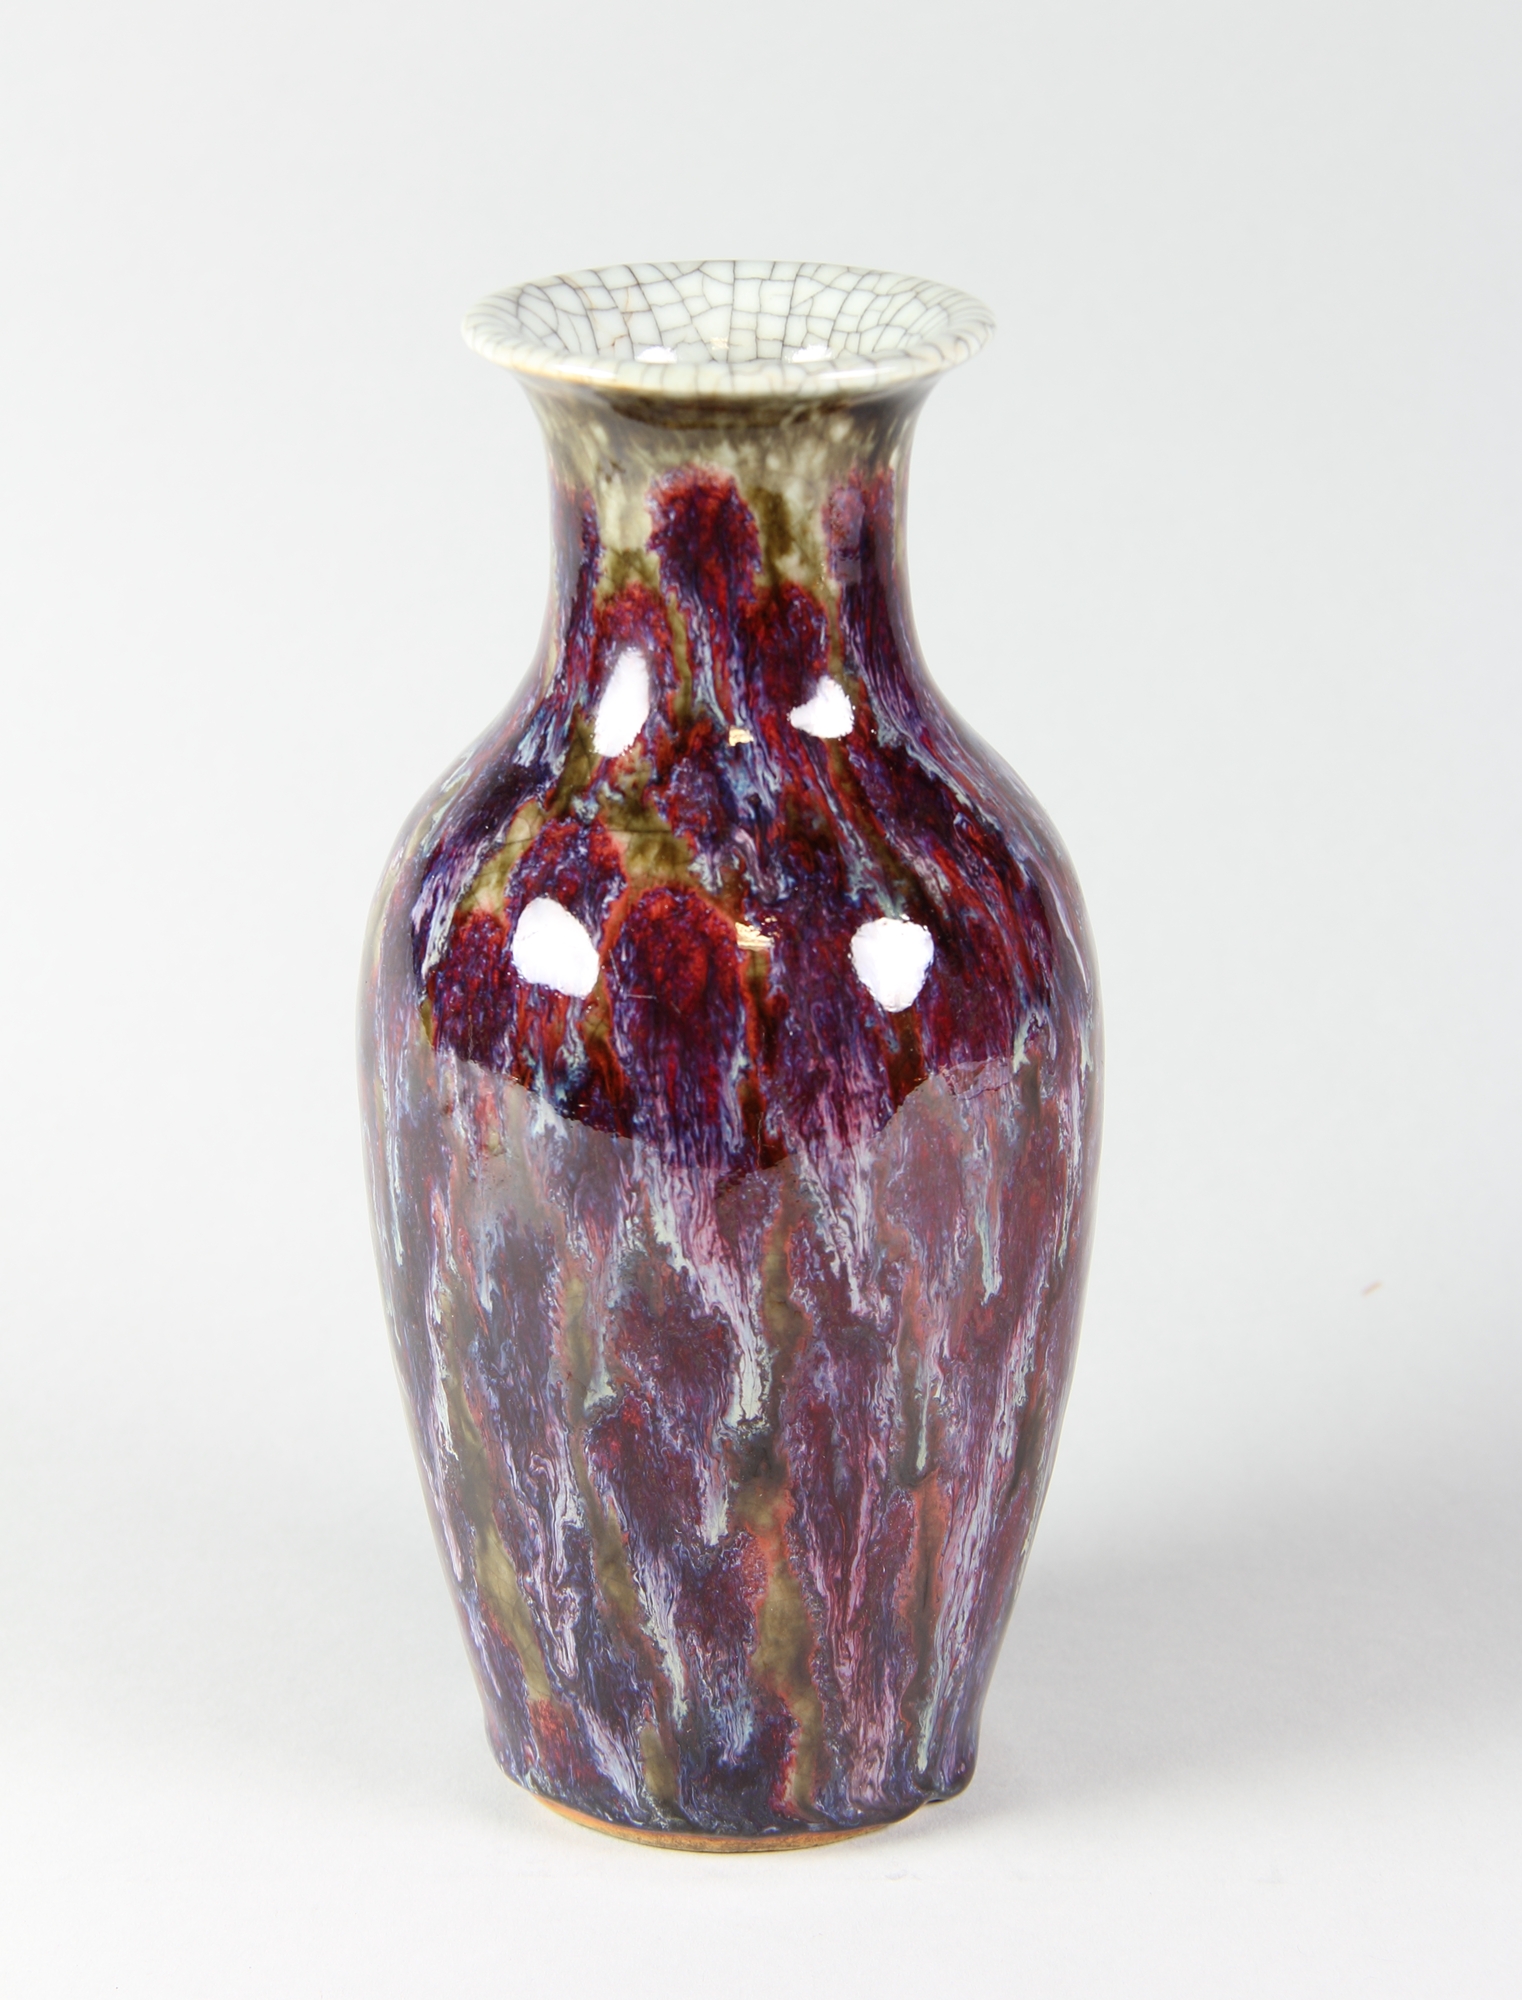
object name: vase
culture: chinese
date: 1767-1833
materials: glaze, porcelain